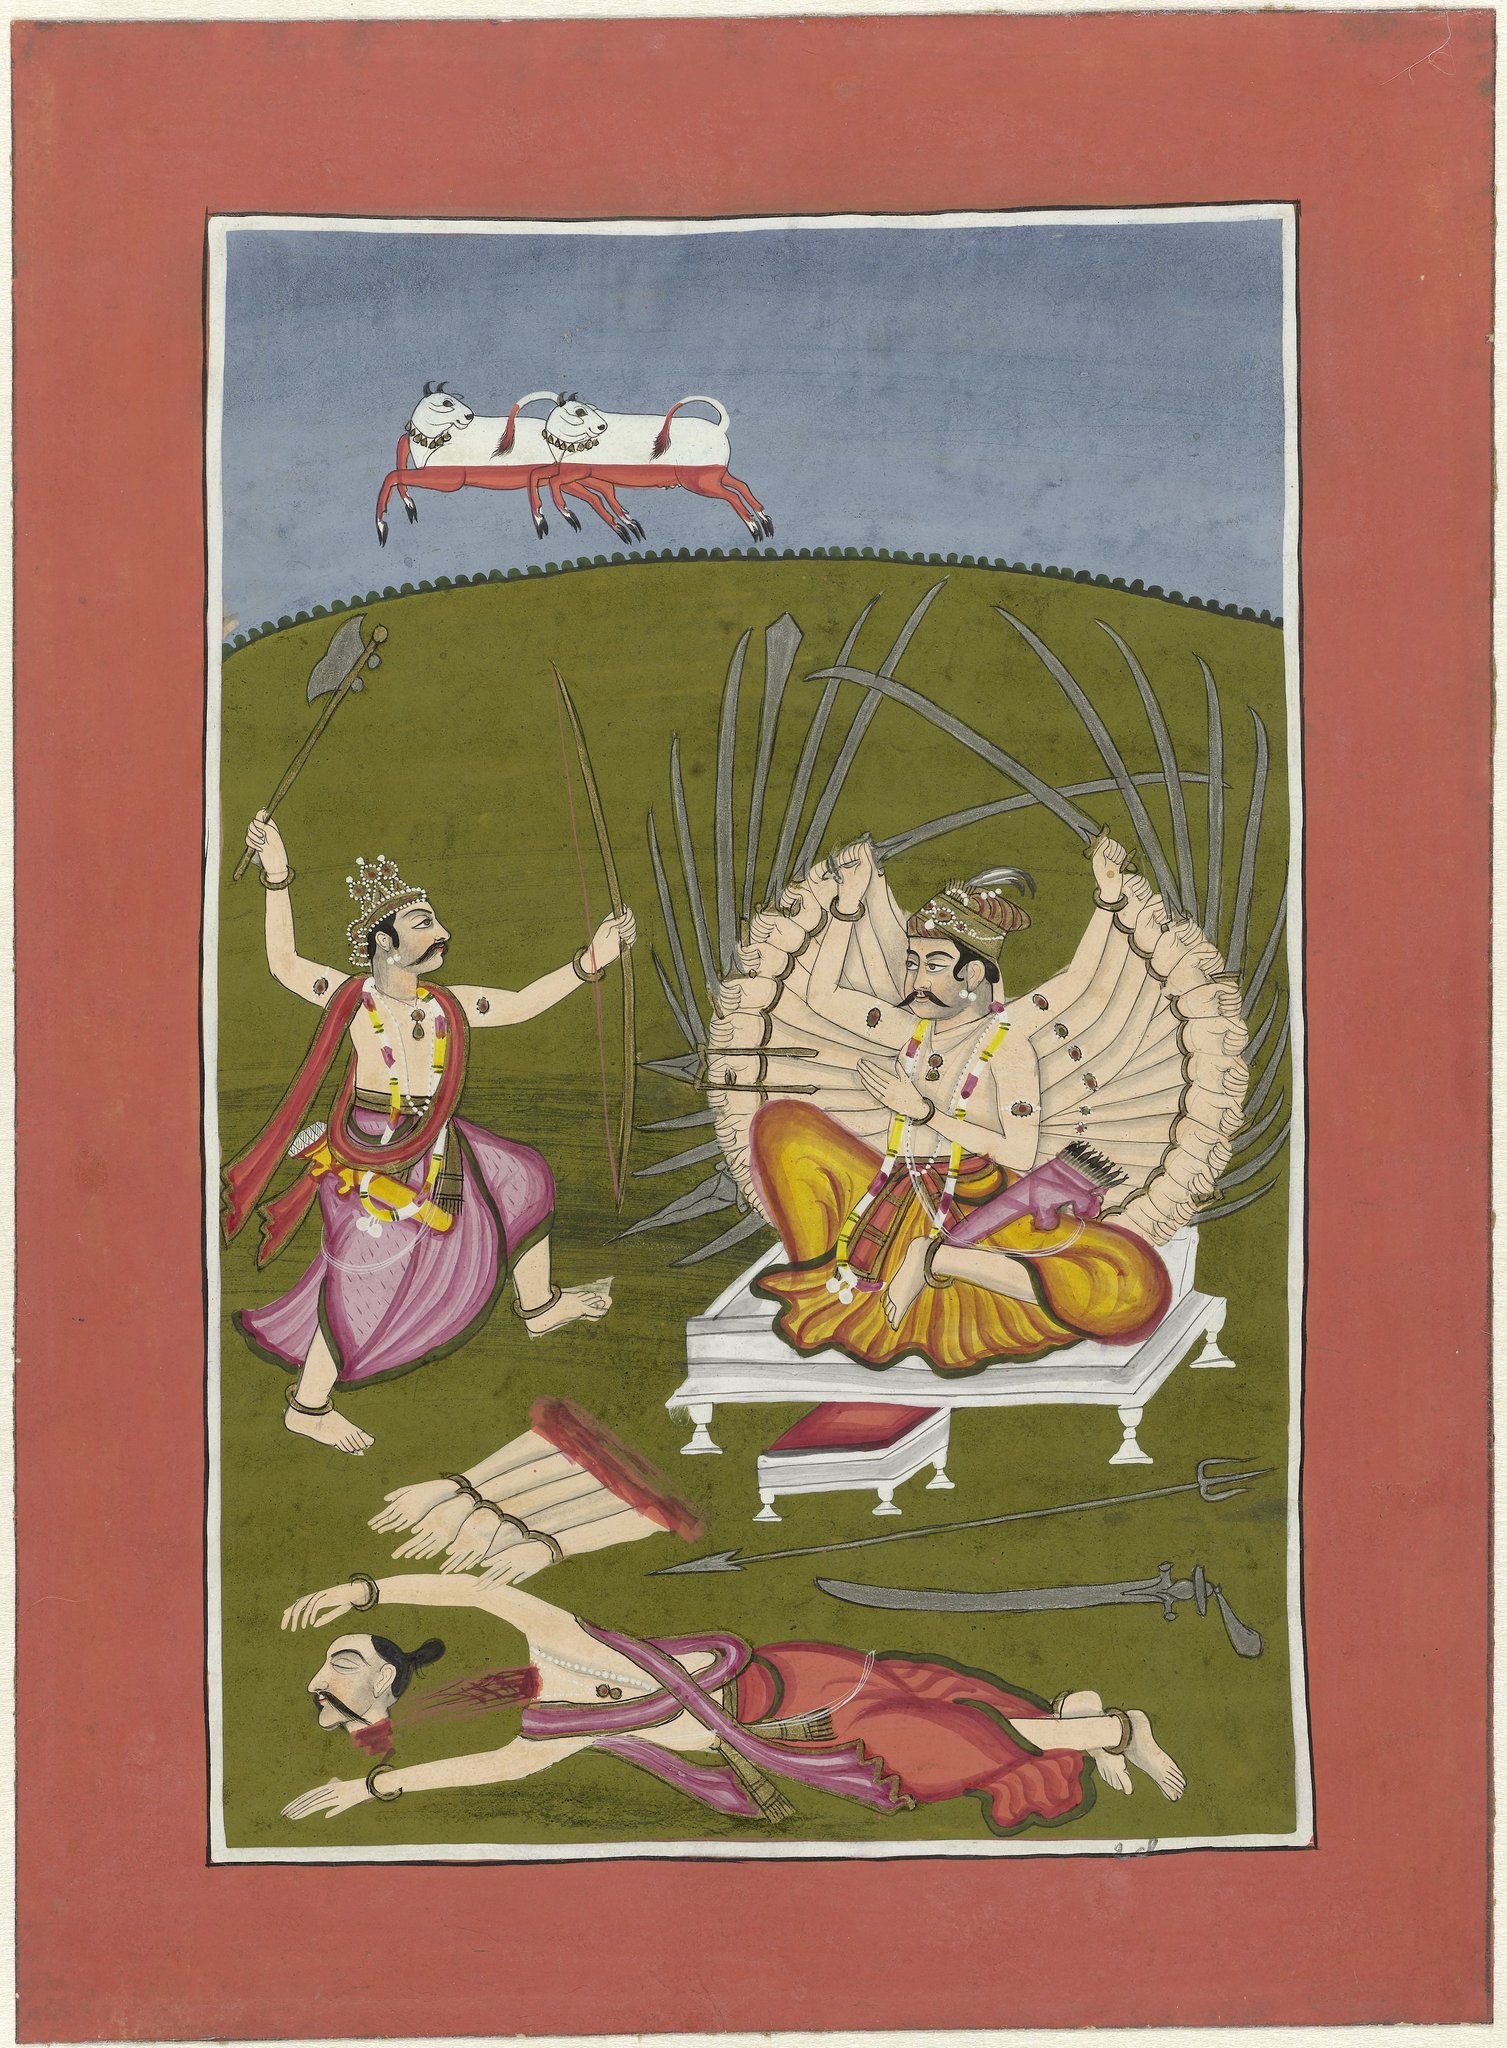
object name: indian miniature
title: Parasurama (incarnatie van Vishnu als Rama-met-een-bijl)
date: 1825-1875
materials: paper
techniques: brush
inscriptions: inscription: ‘6. Parasurama; The Death of Kartavirya’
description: Vishnu als Parasurama trekt met een bijl ten strijde tegen een veelarmige krijgsman. De voorstelling is omlijst door een smal wit biesje, daaromheen een brede oranjerode sierrand met zwarte kaderlijnen; dit blad is op een blad kardoespapier geplakt waarop een zwarte kaderlijn in potlood is getekend.